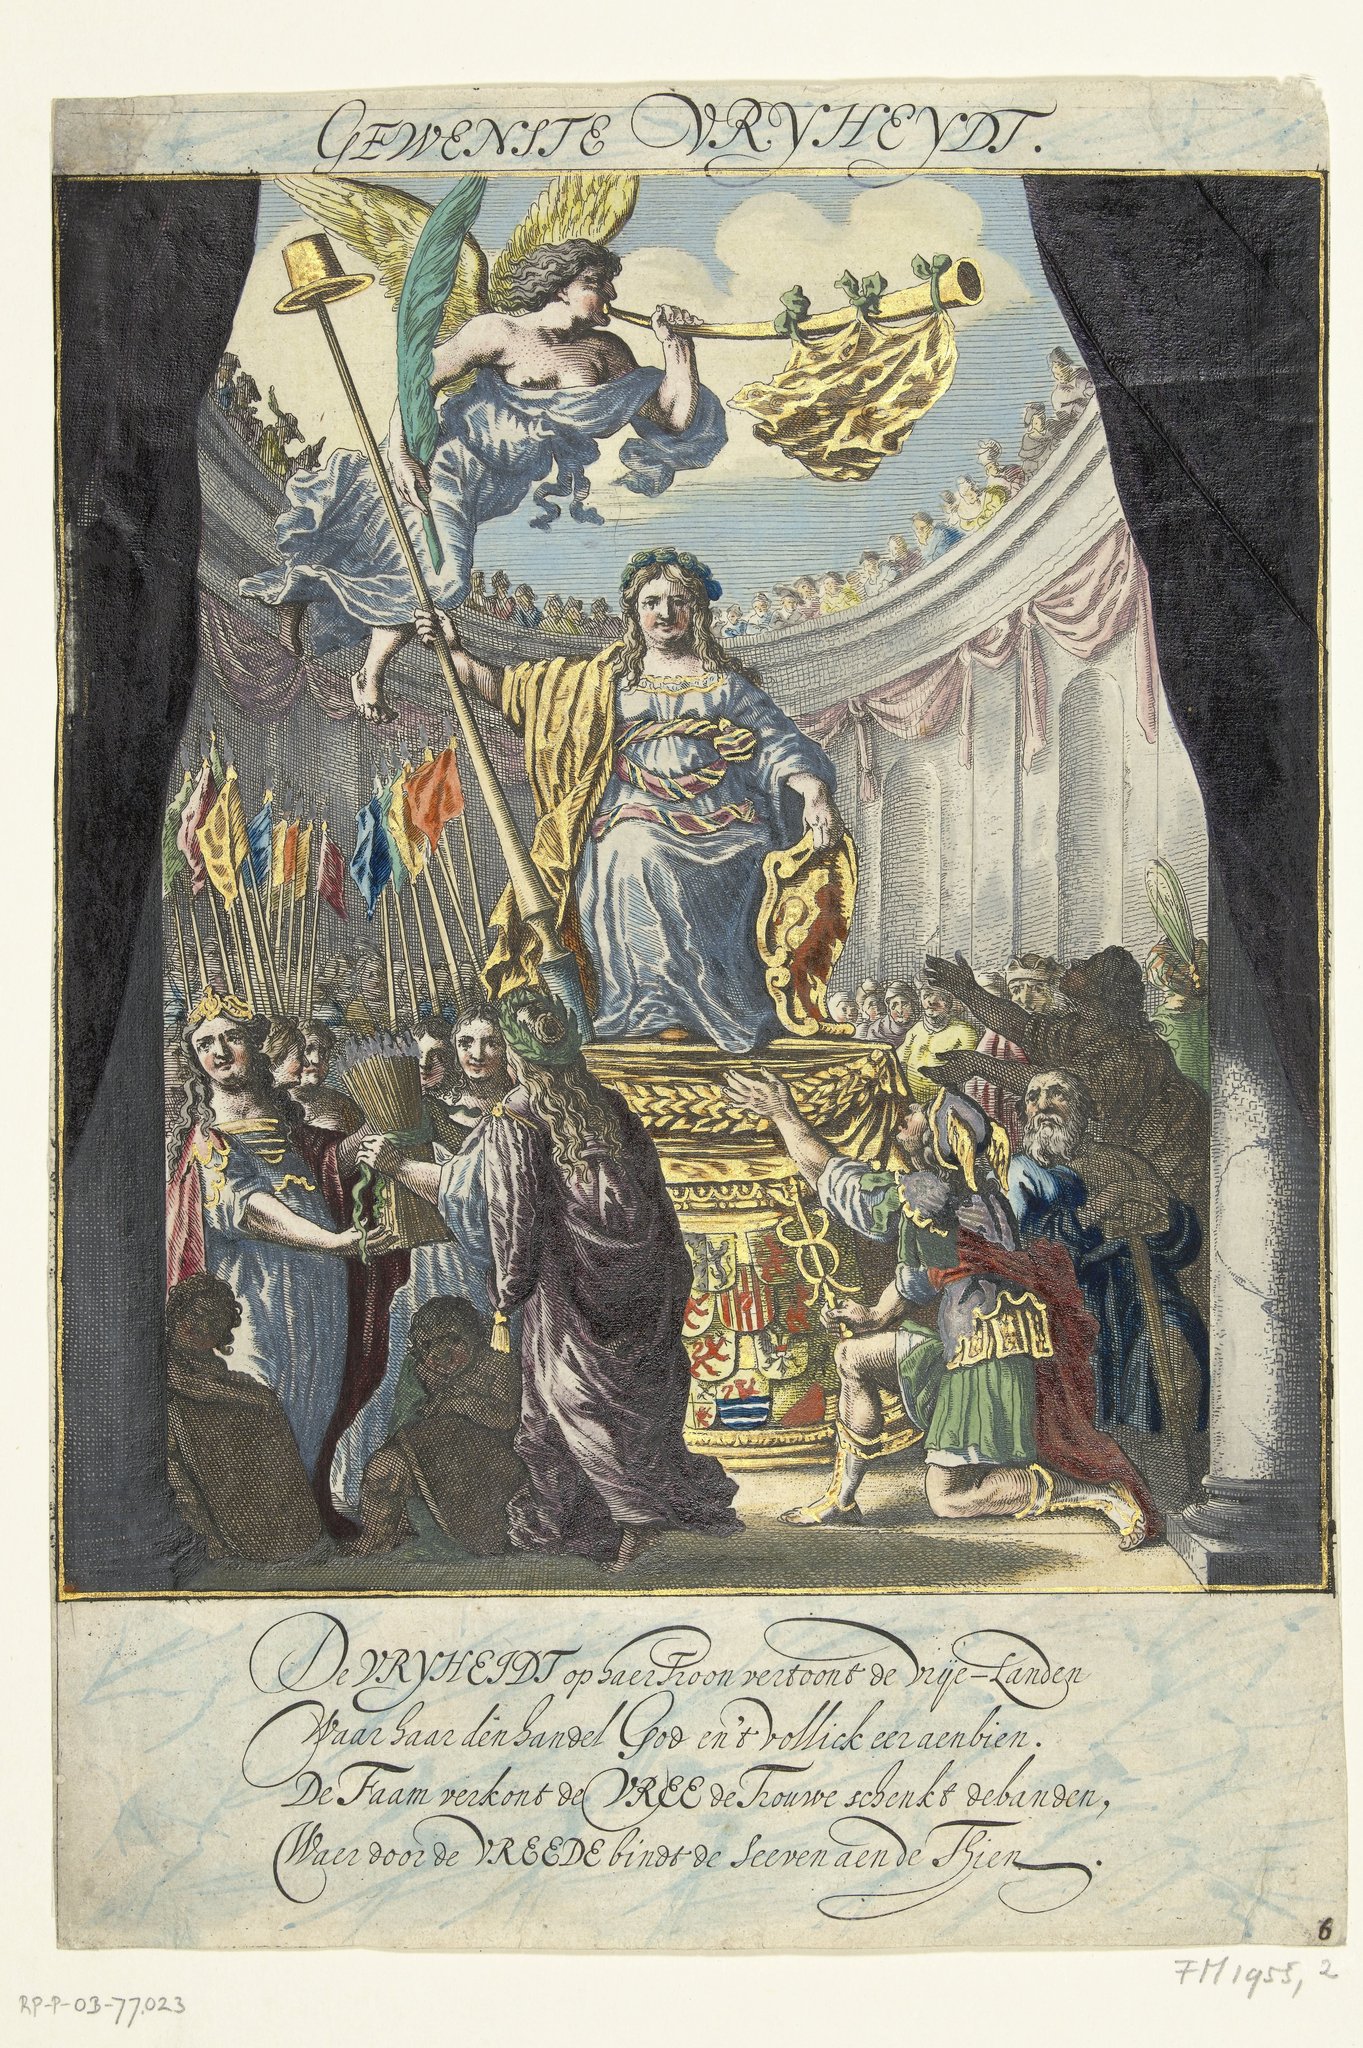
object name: print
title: Vertoning van de Gewenste Vrijheid, 1648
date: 1649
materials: paper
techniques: etching, hand coloring, lacquer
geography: amsterdam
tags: theatre, theatrical performance, festivities on events of national importance, fame; 'fama', 'fama buona', 'fama chiara' (ripa), freedom, liberty; 'libertà' (ripa)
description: Vertoning van de Gewenste Vrijheid. Onderdeel van de vertoningen opgevoerd op 23 juni 1648 op de Schouwburg te Amsterdam naar aanleiding van het sluiten van de Vrede van Munster. De tweede voorstelling toont de personificatie van de Vrijheid zittend op een voetstuk, in de lucht de Faam. In het onderschrift een vers van 4 regels in het Nederlands. Genummerd met pen rechtsonder: 6.